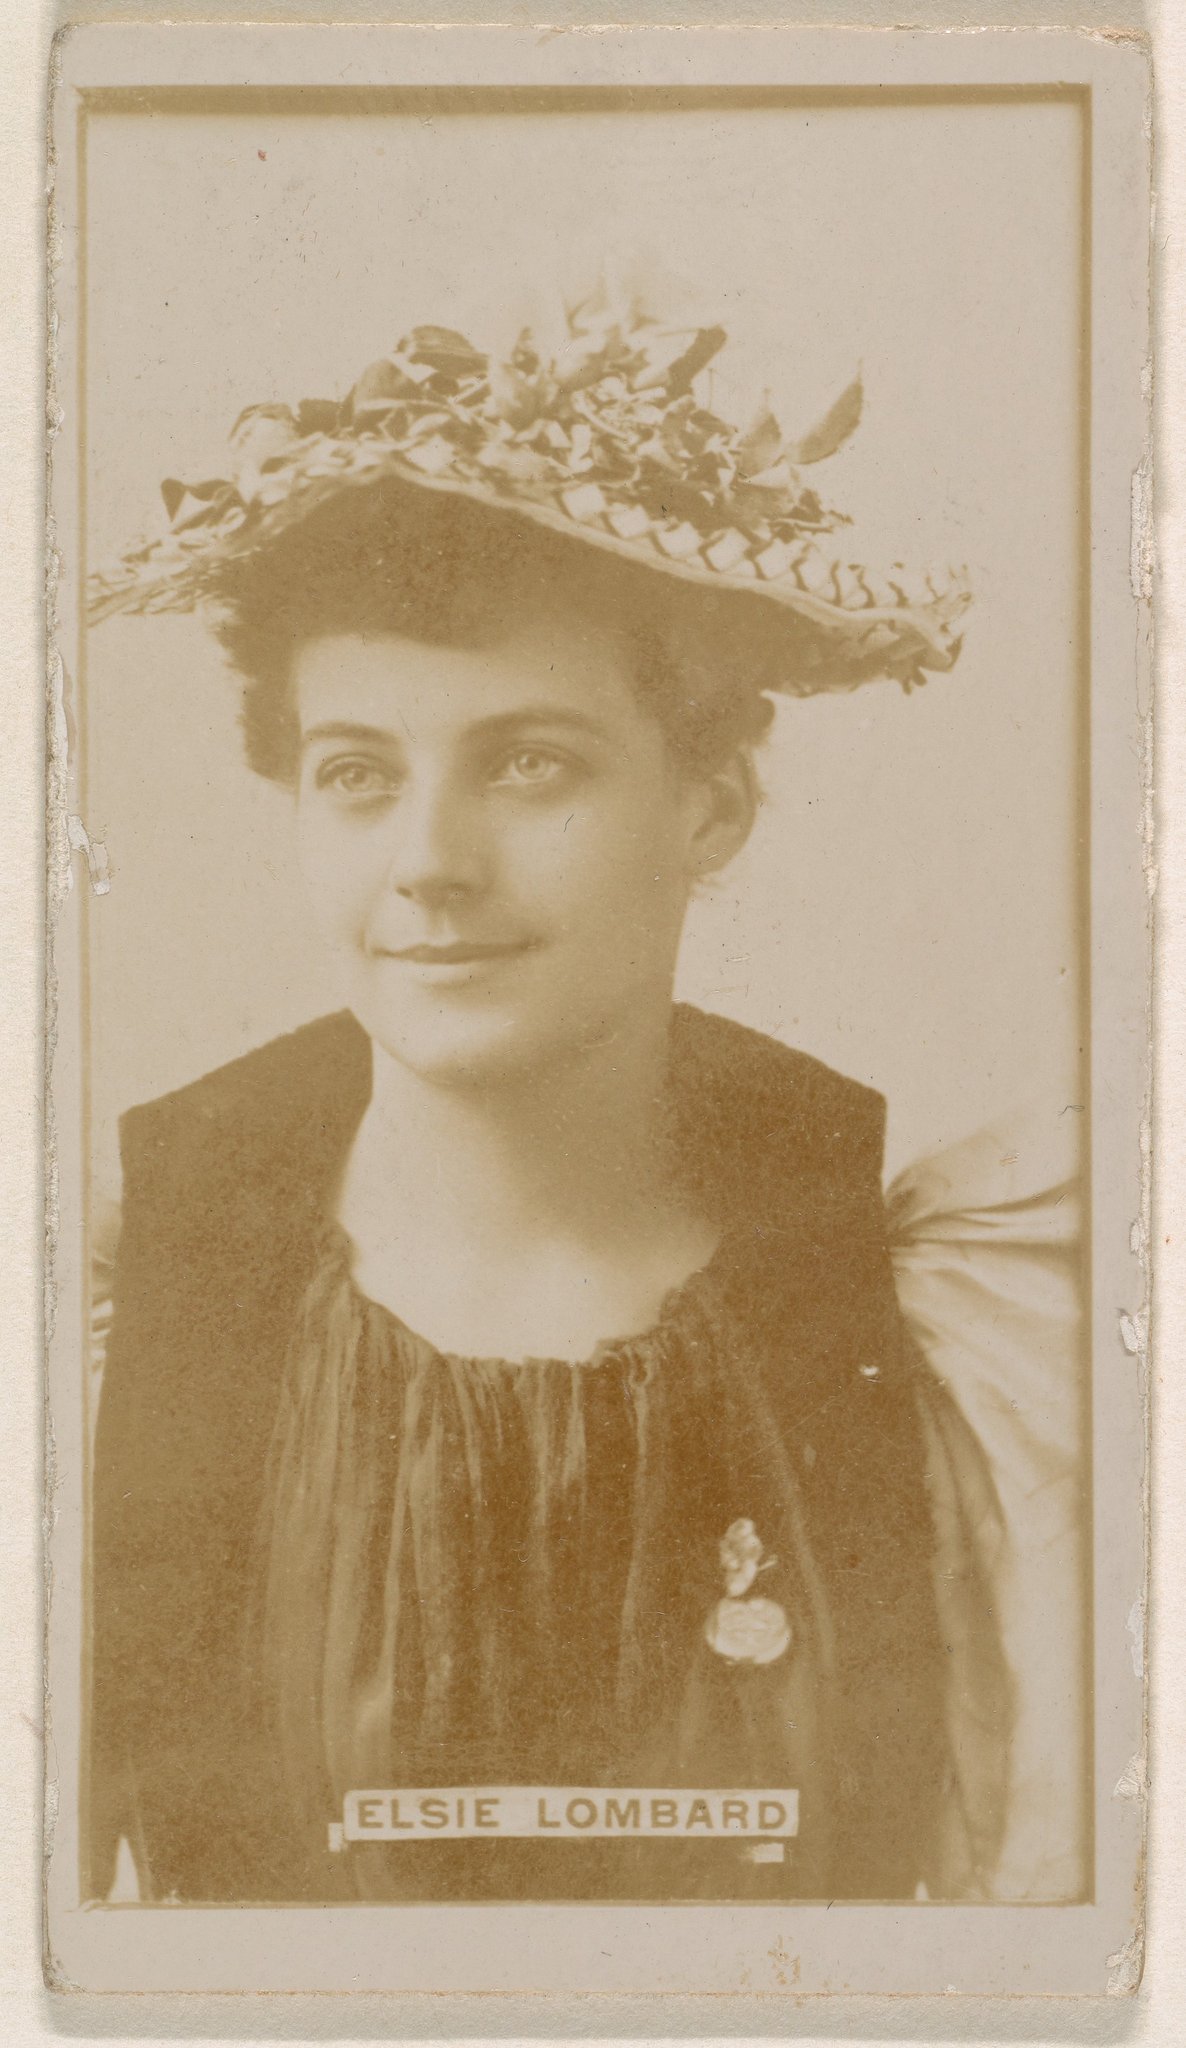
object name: photograph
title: Elsie Lombard, from the Actresses series (N245) issued by Kinney Brothers to promote Sweet Caporal Cigarettes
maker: kinney brothers tobacco company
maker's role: publisher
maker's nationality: american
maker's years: 1869-2011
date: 1890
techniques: albumen silver print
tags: portraits,women,actresses